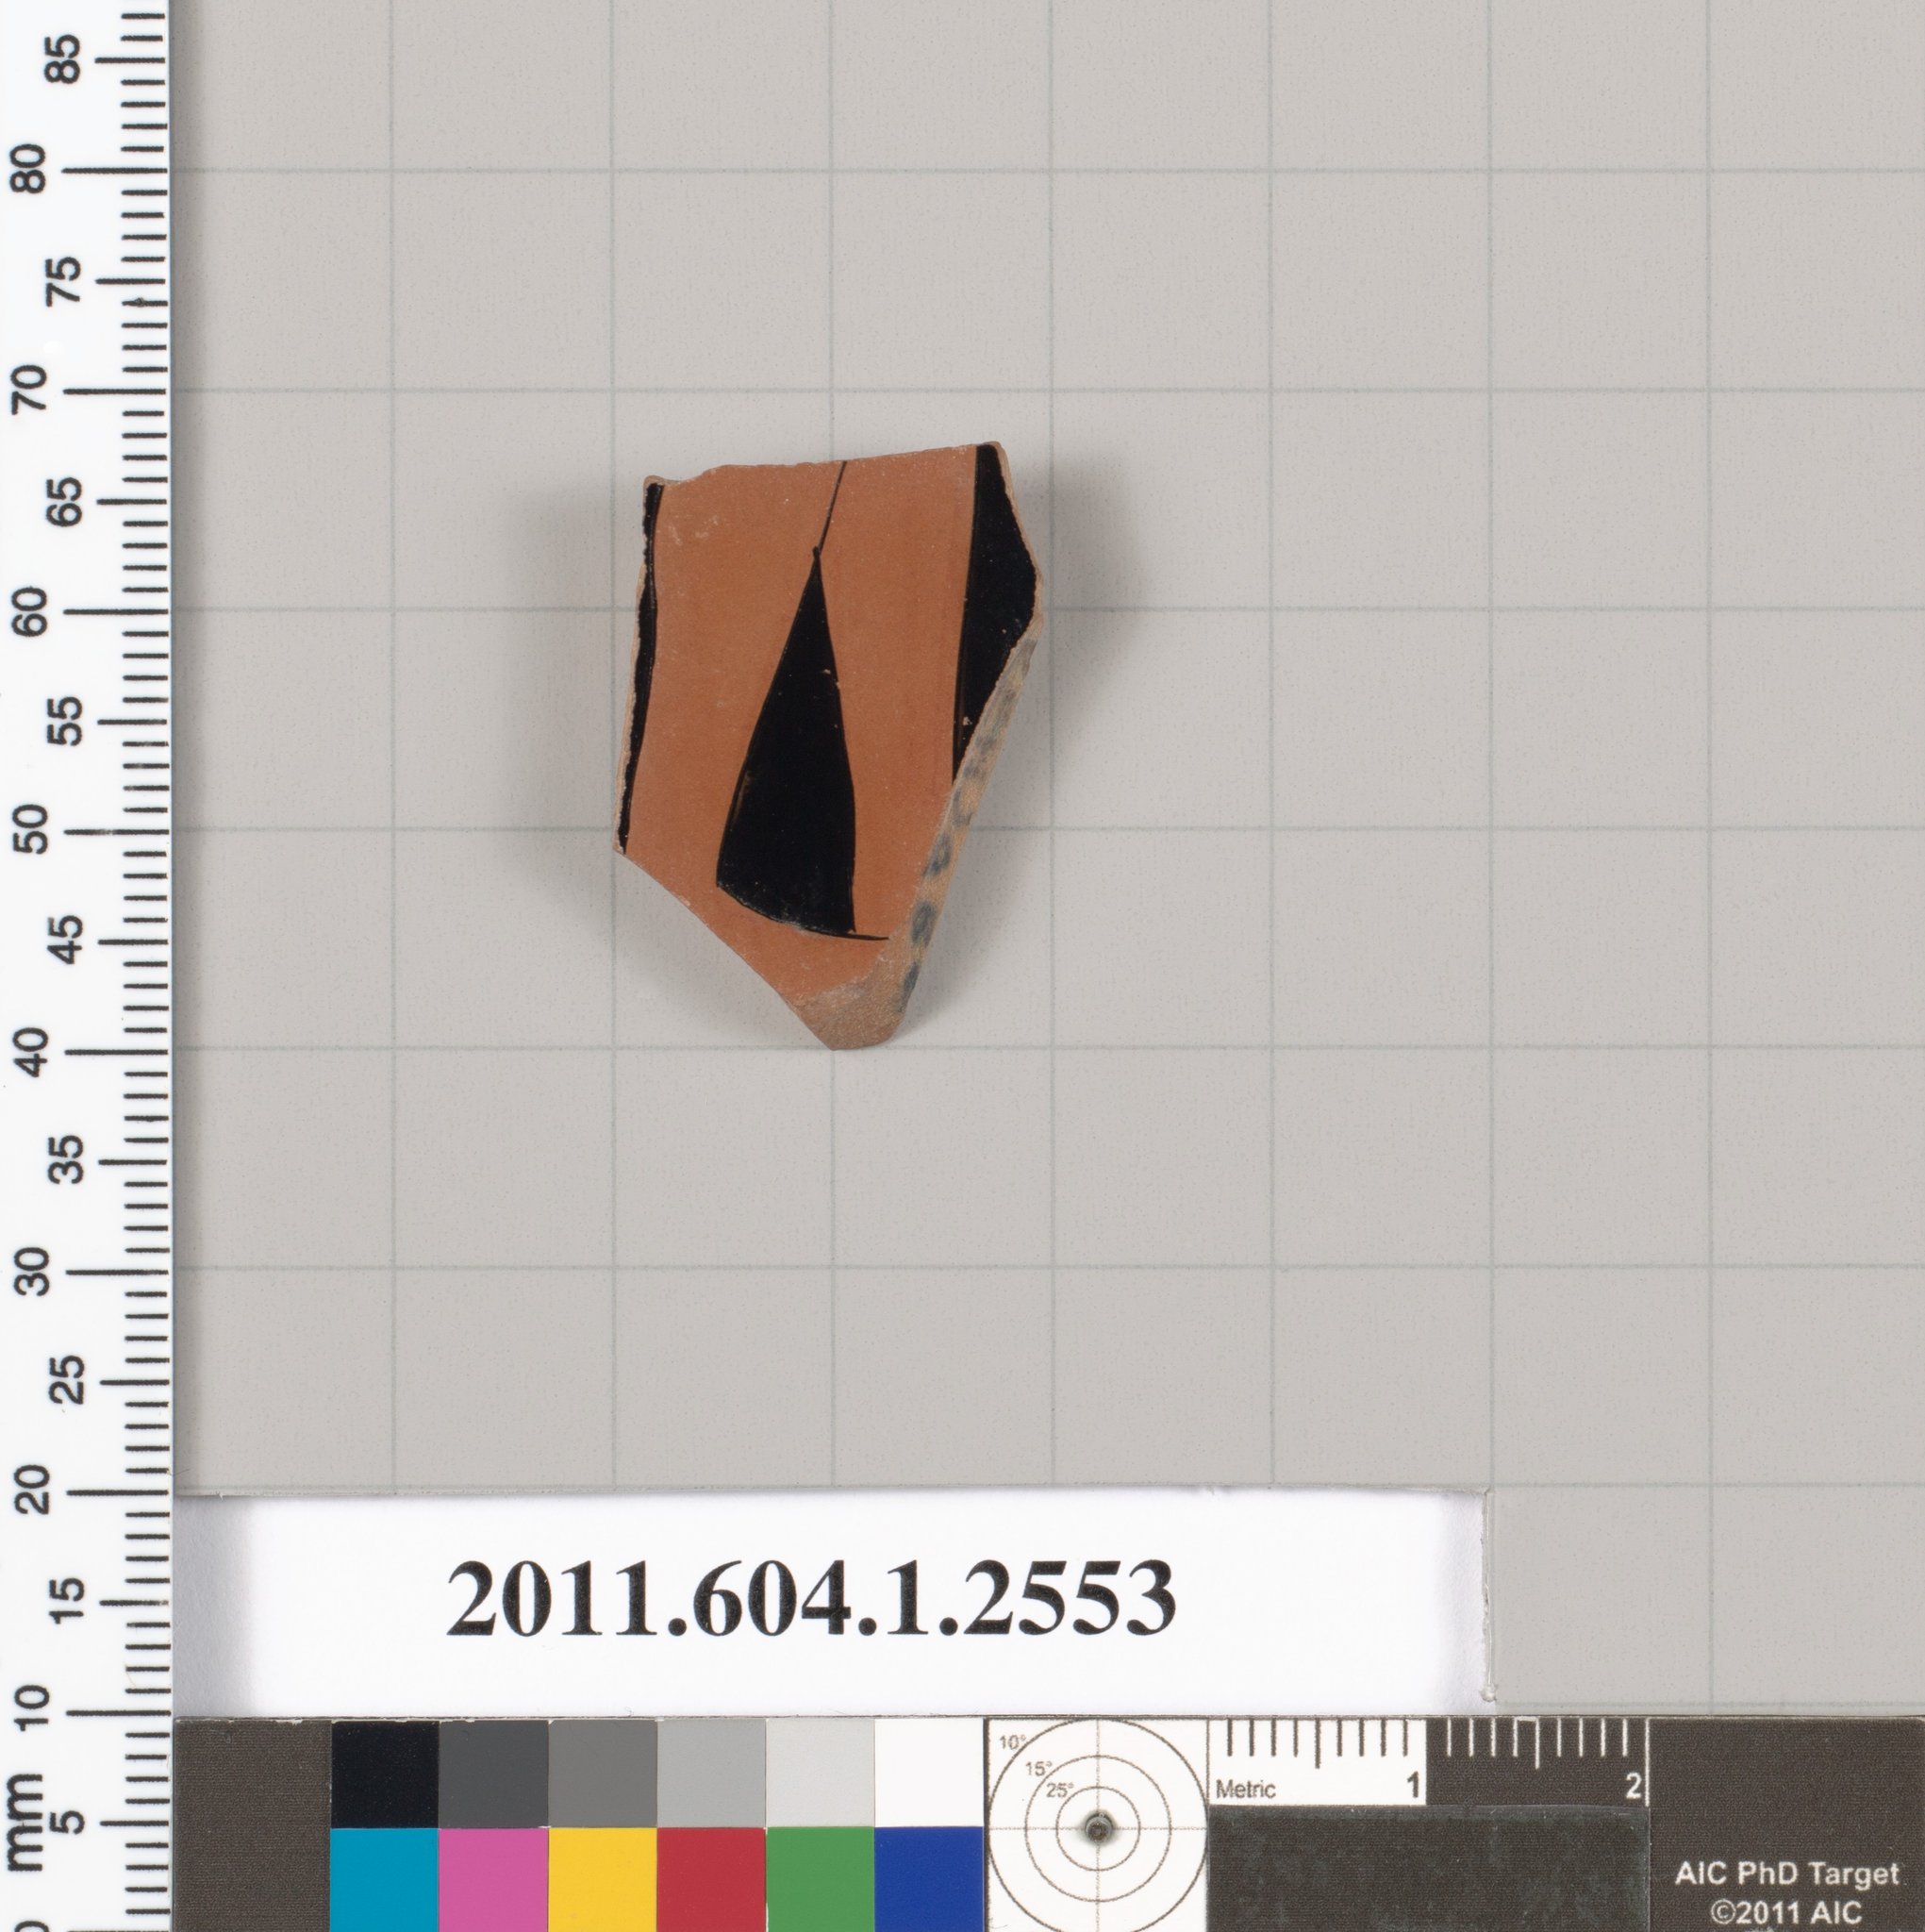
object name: kylix fragment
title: Terracotta fragment of a kylix (drinking cup)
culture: greek, attic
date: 475-451 BCE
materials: terracotta